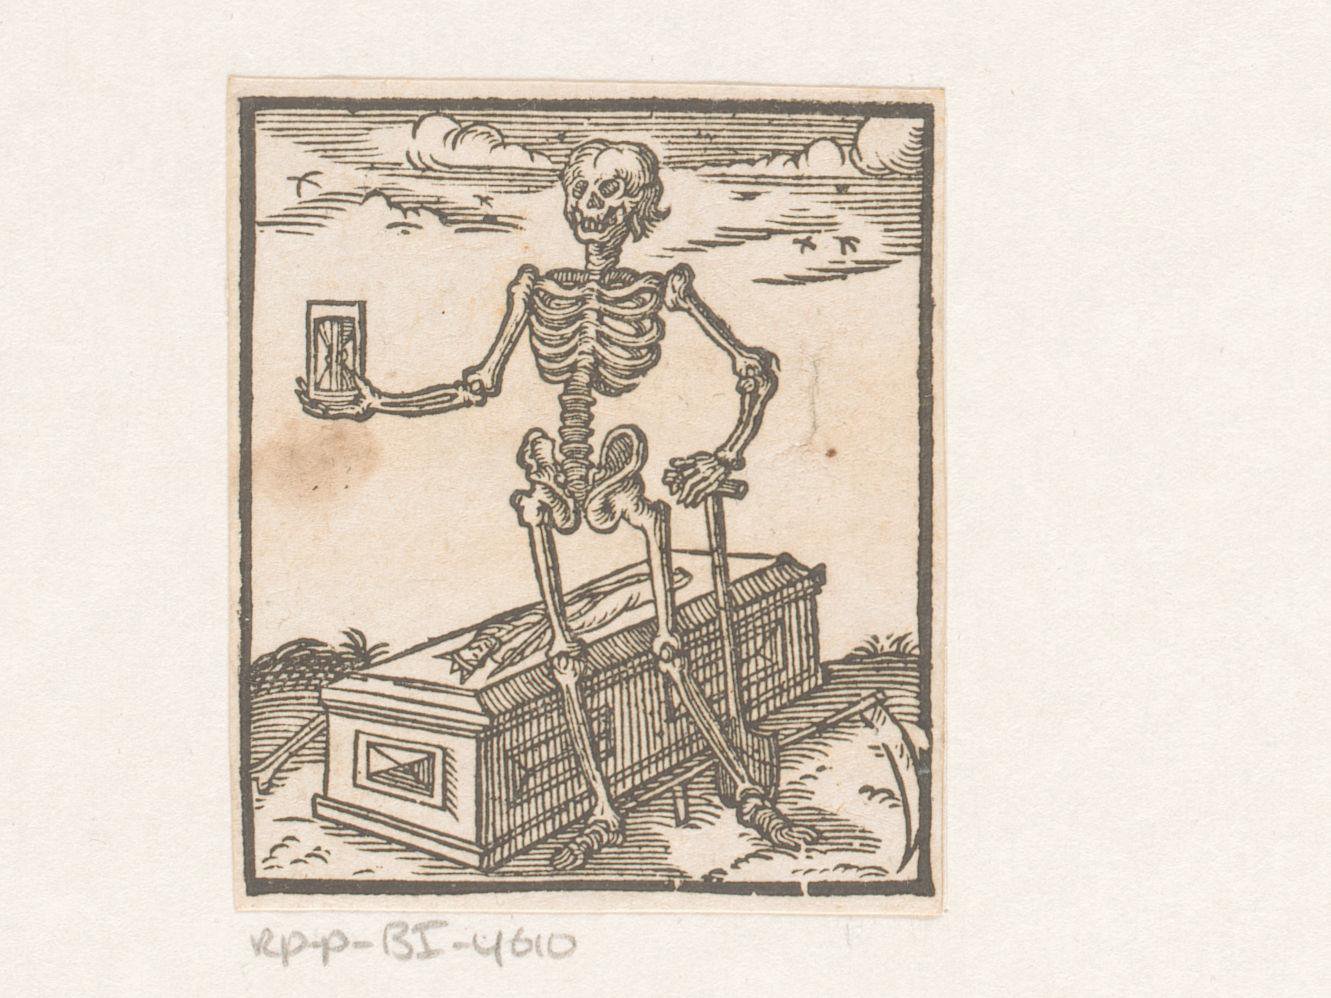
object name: print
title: Dood met een zandloper, een zeis, een schop en een doodskist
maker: Anonymous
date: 1600-1699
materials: paper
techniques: woodcut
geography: netherlands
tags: death as skeleton (+ death with scythe), coffin, hourglass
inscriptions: collector's mark: Lugt 240